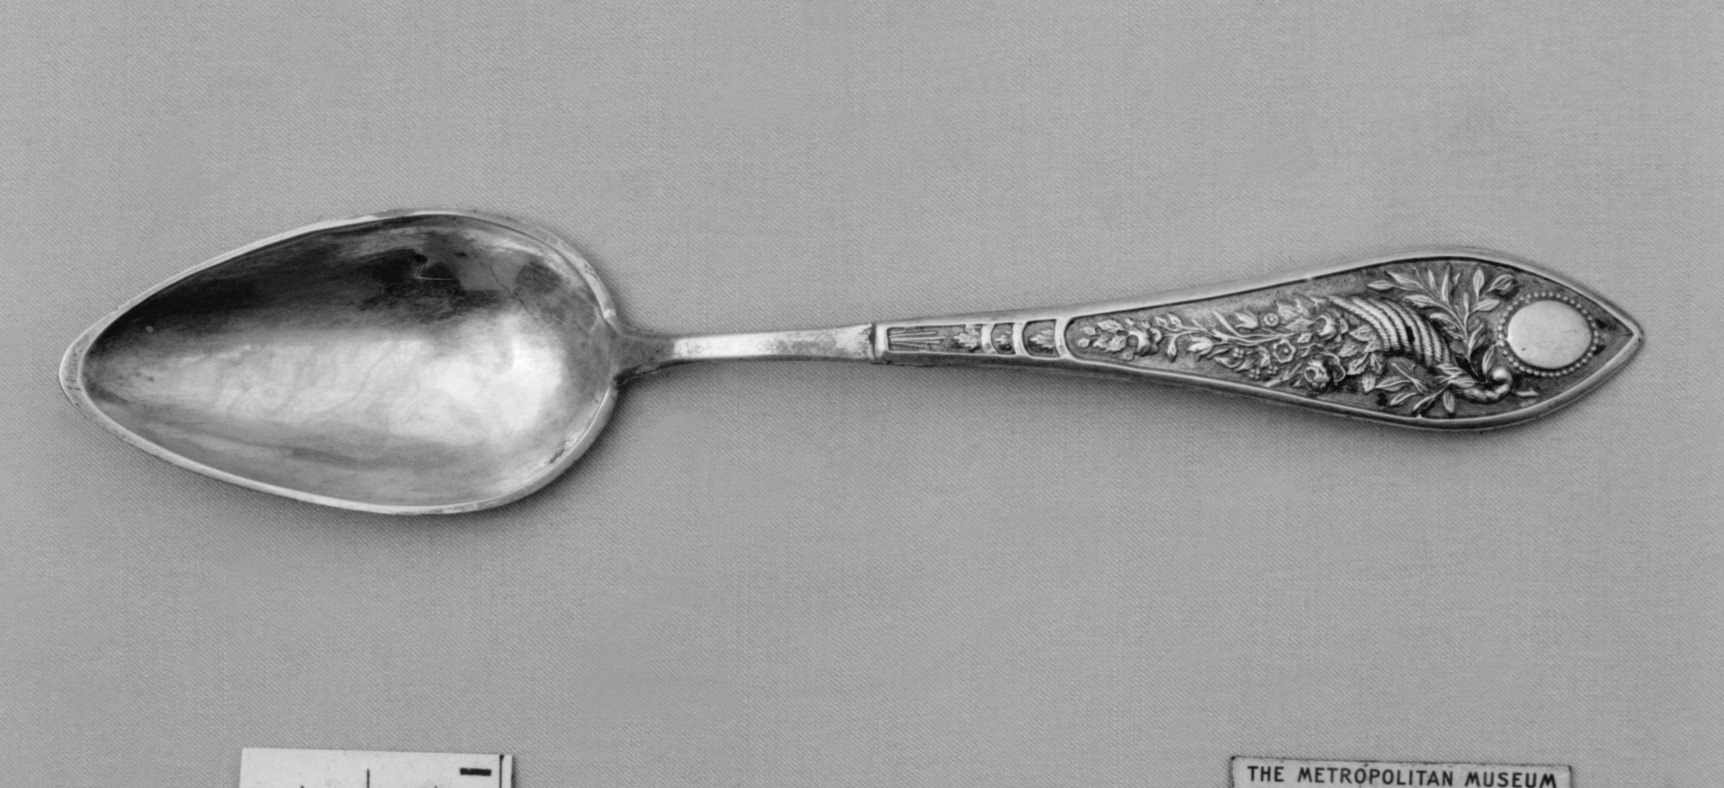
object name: teaspoon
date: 1801-1900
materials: silver